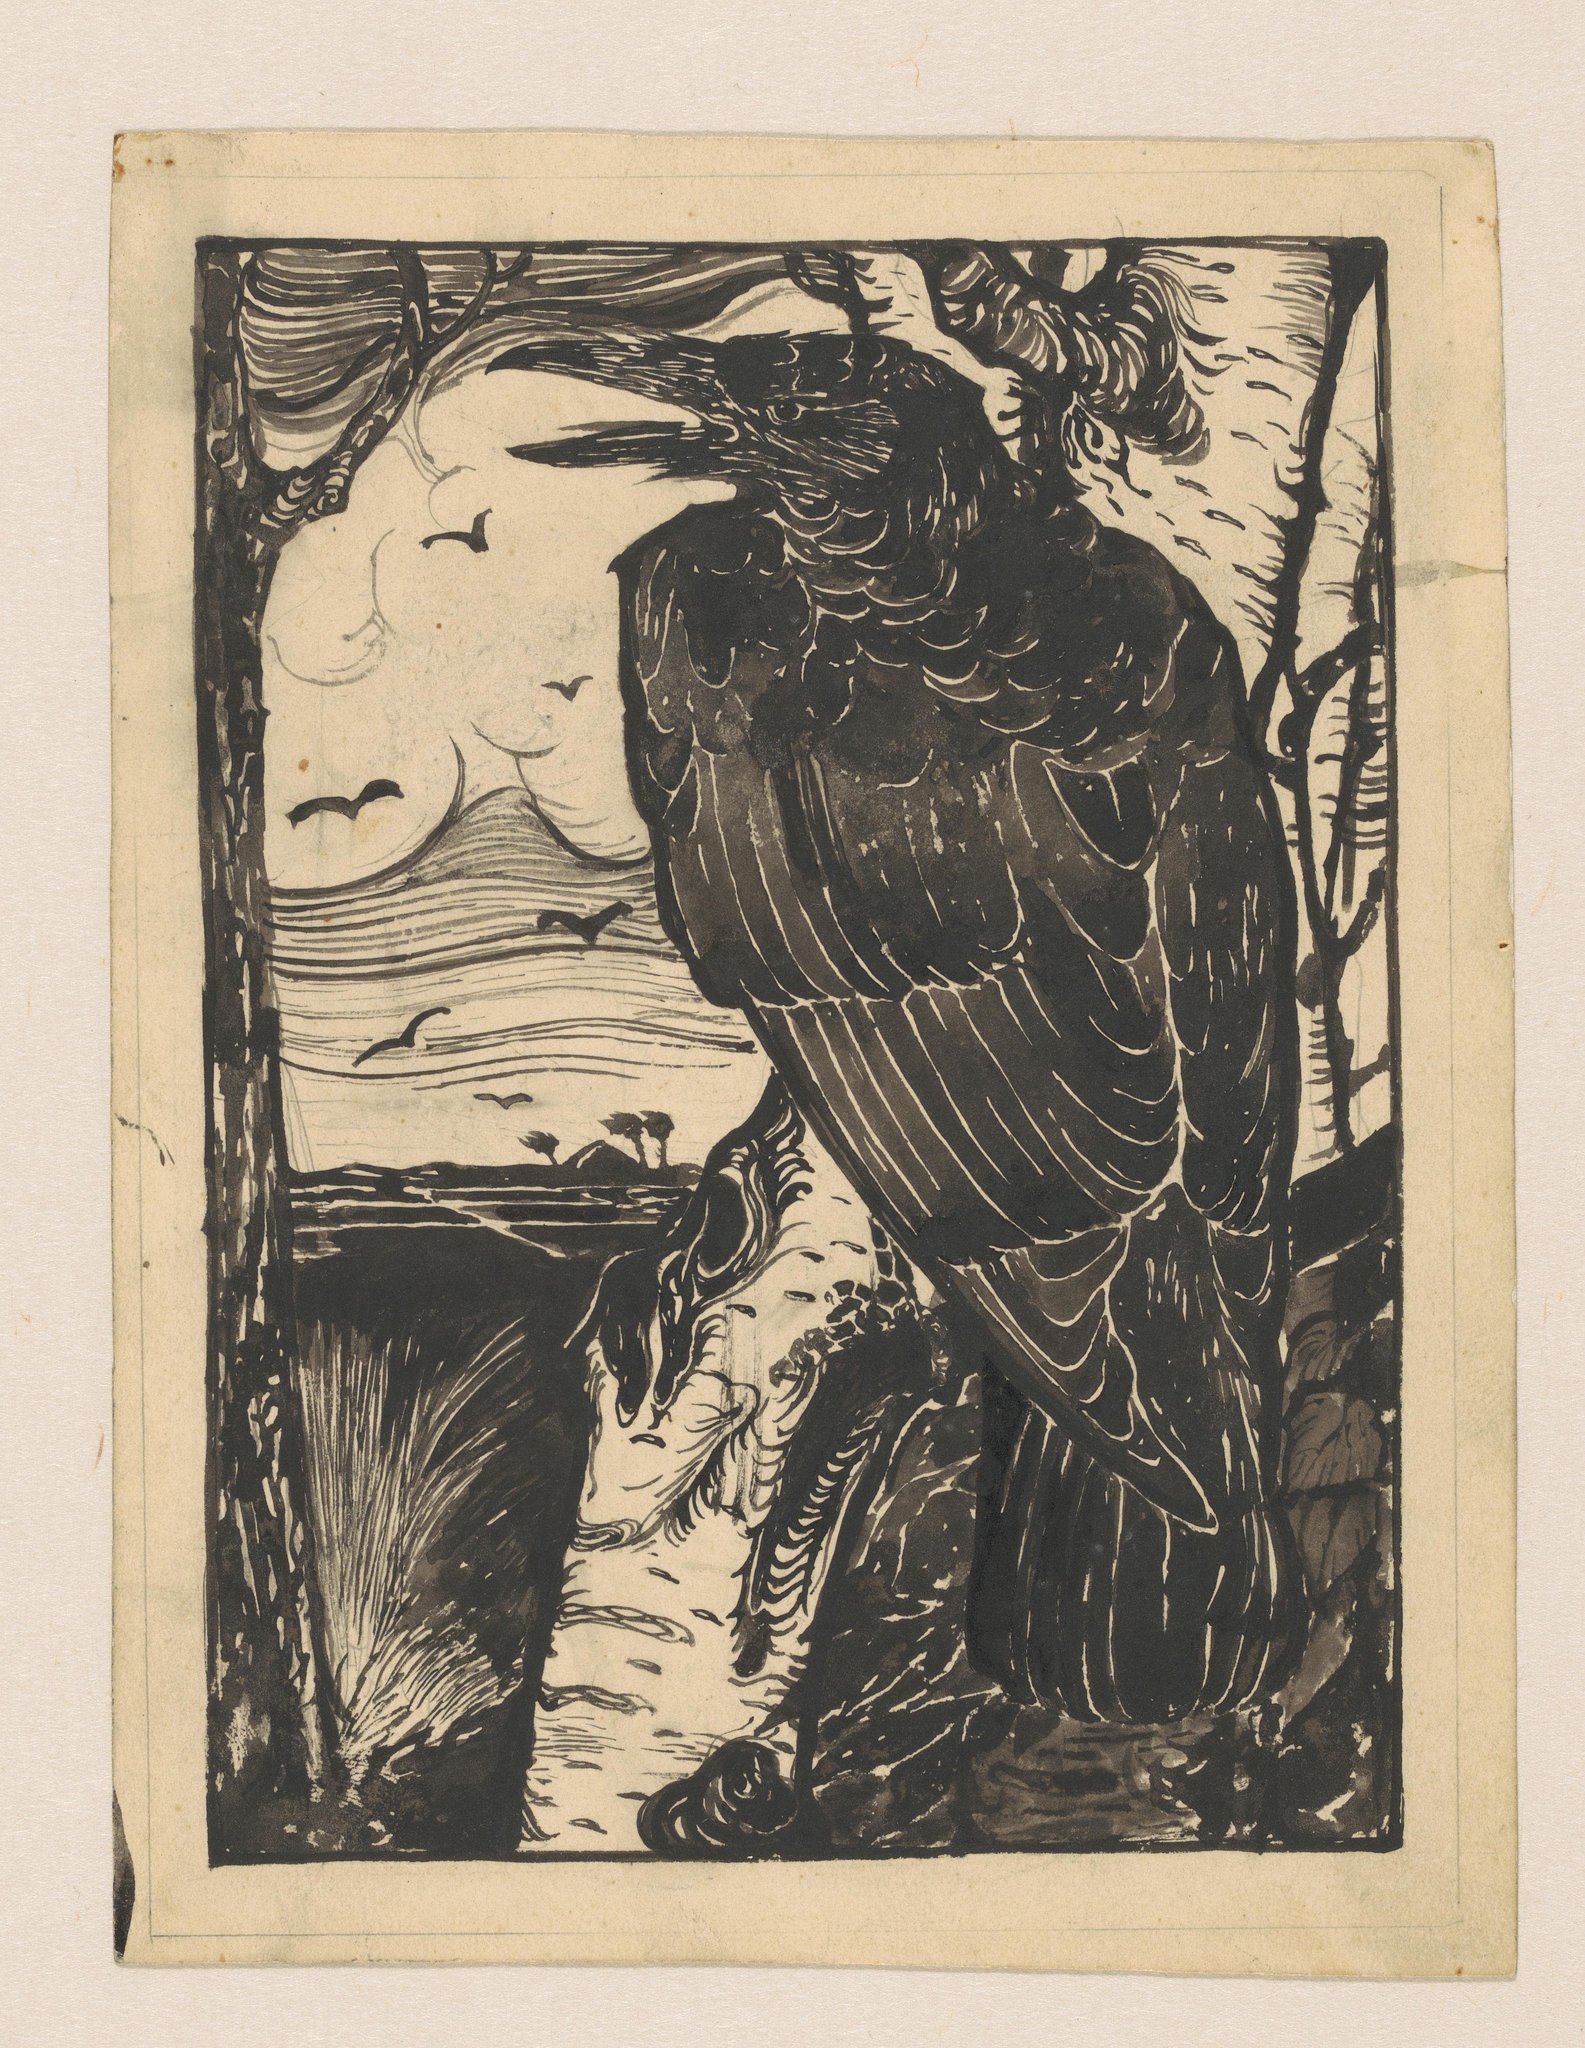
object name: design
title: Raaf op berkenboom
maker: jan mankes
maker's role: draughtsman, painter, print maker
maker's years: 1889-1920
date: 1918-1920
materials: ink, paper, pencil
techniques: brush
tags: song-birds: raven